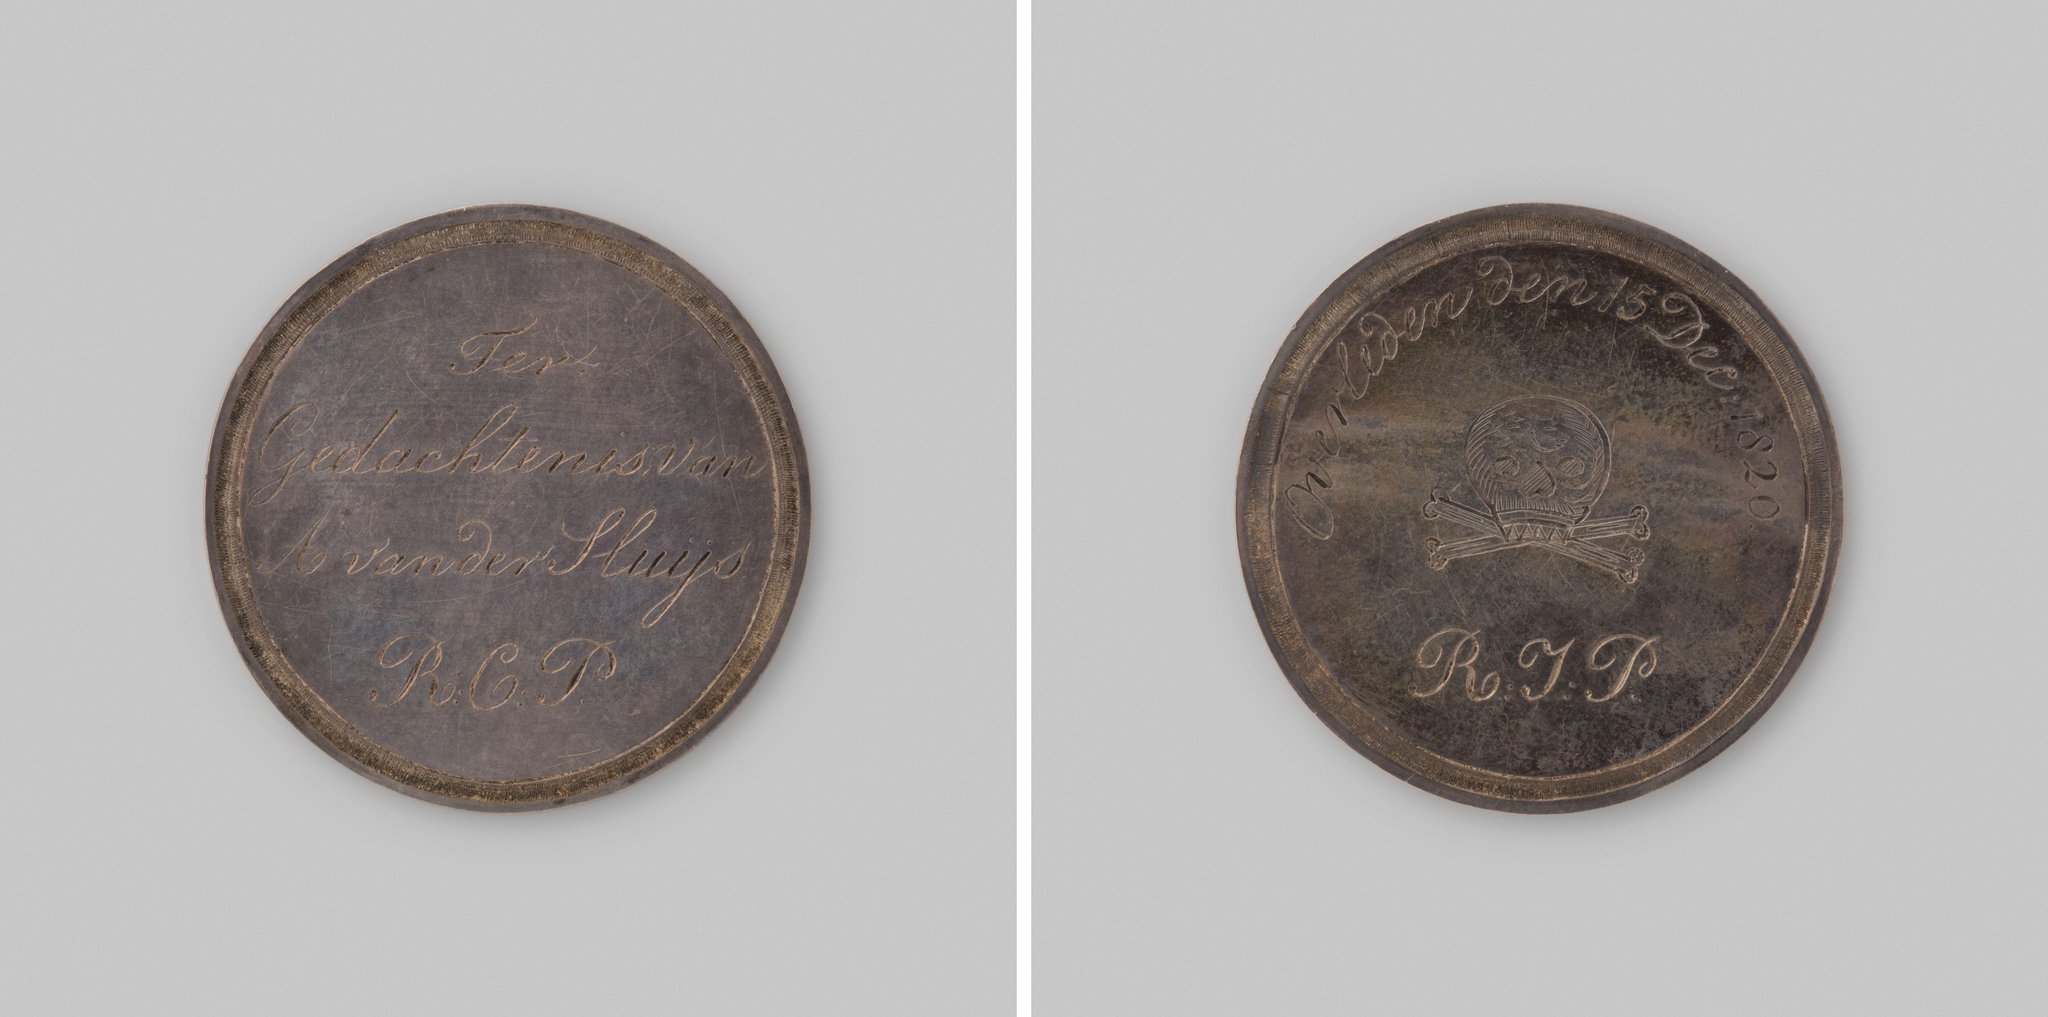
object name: family medal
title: Overlijden van A. van der Sluis, pastoor te 's-Gravenhage 1820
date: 1820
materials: silver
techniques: engraving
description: Gegraveerde zilveren penning, op de voorzijde vier regels tekst, op de keerzijde een doodshoofd met omschrift boven R.I.P.